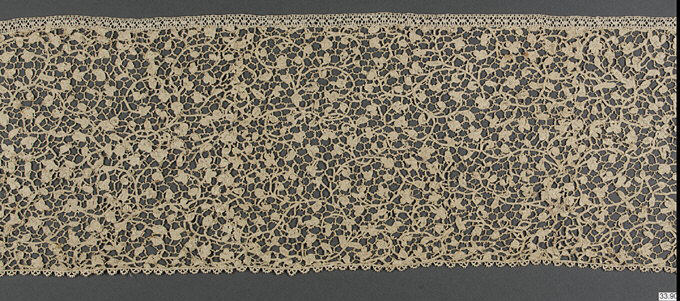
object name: border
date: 1601-1700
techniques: lace